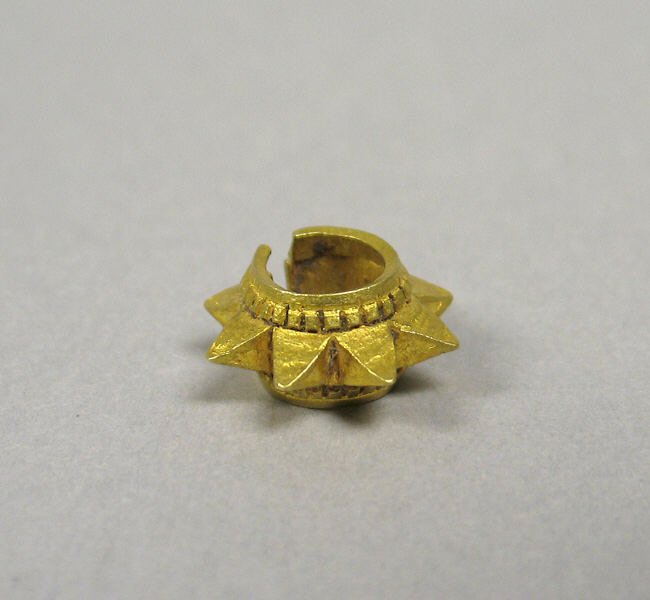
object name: ornament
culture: indonesian, central java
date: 701-1200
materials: gold